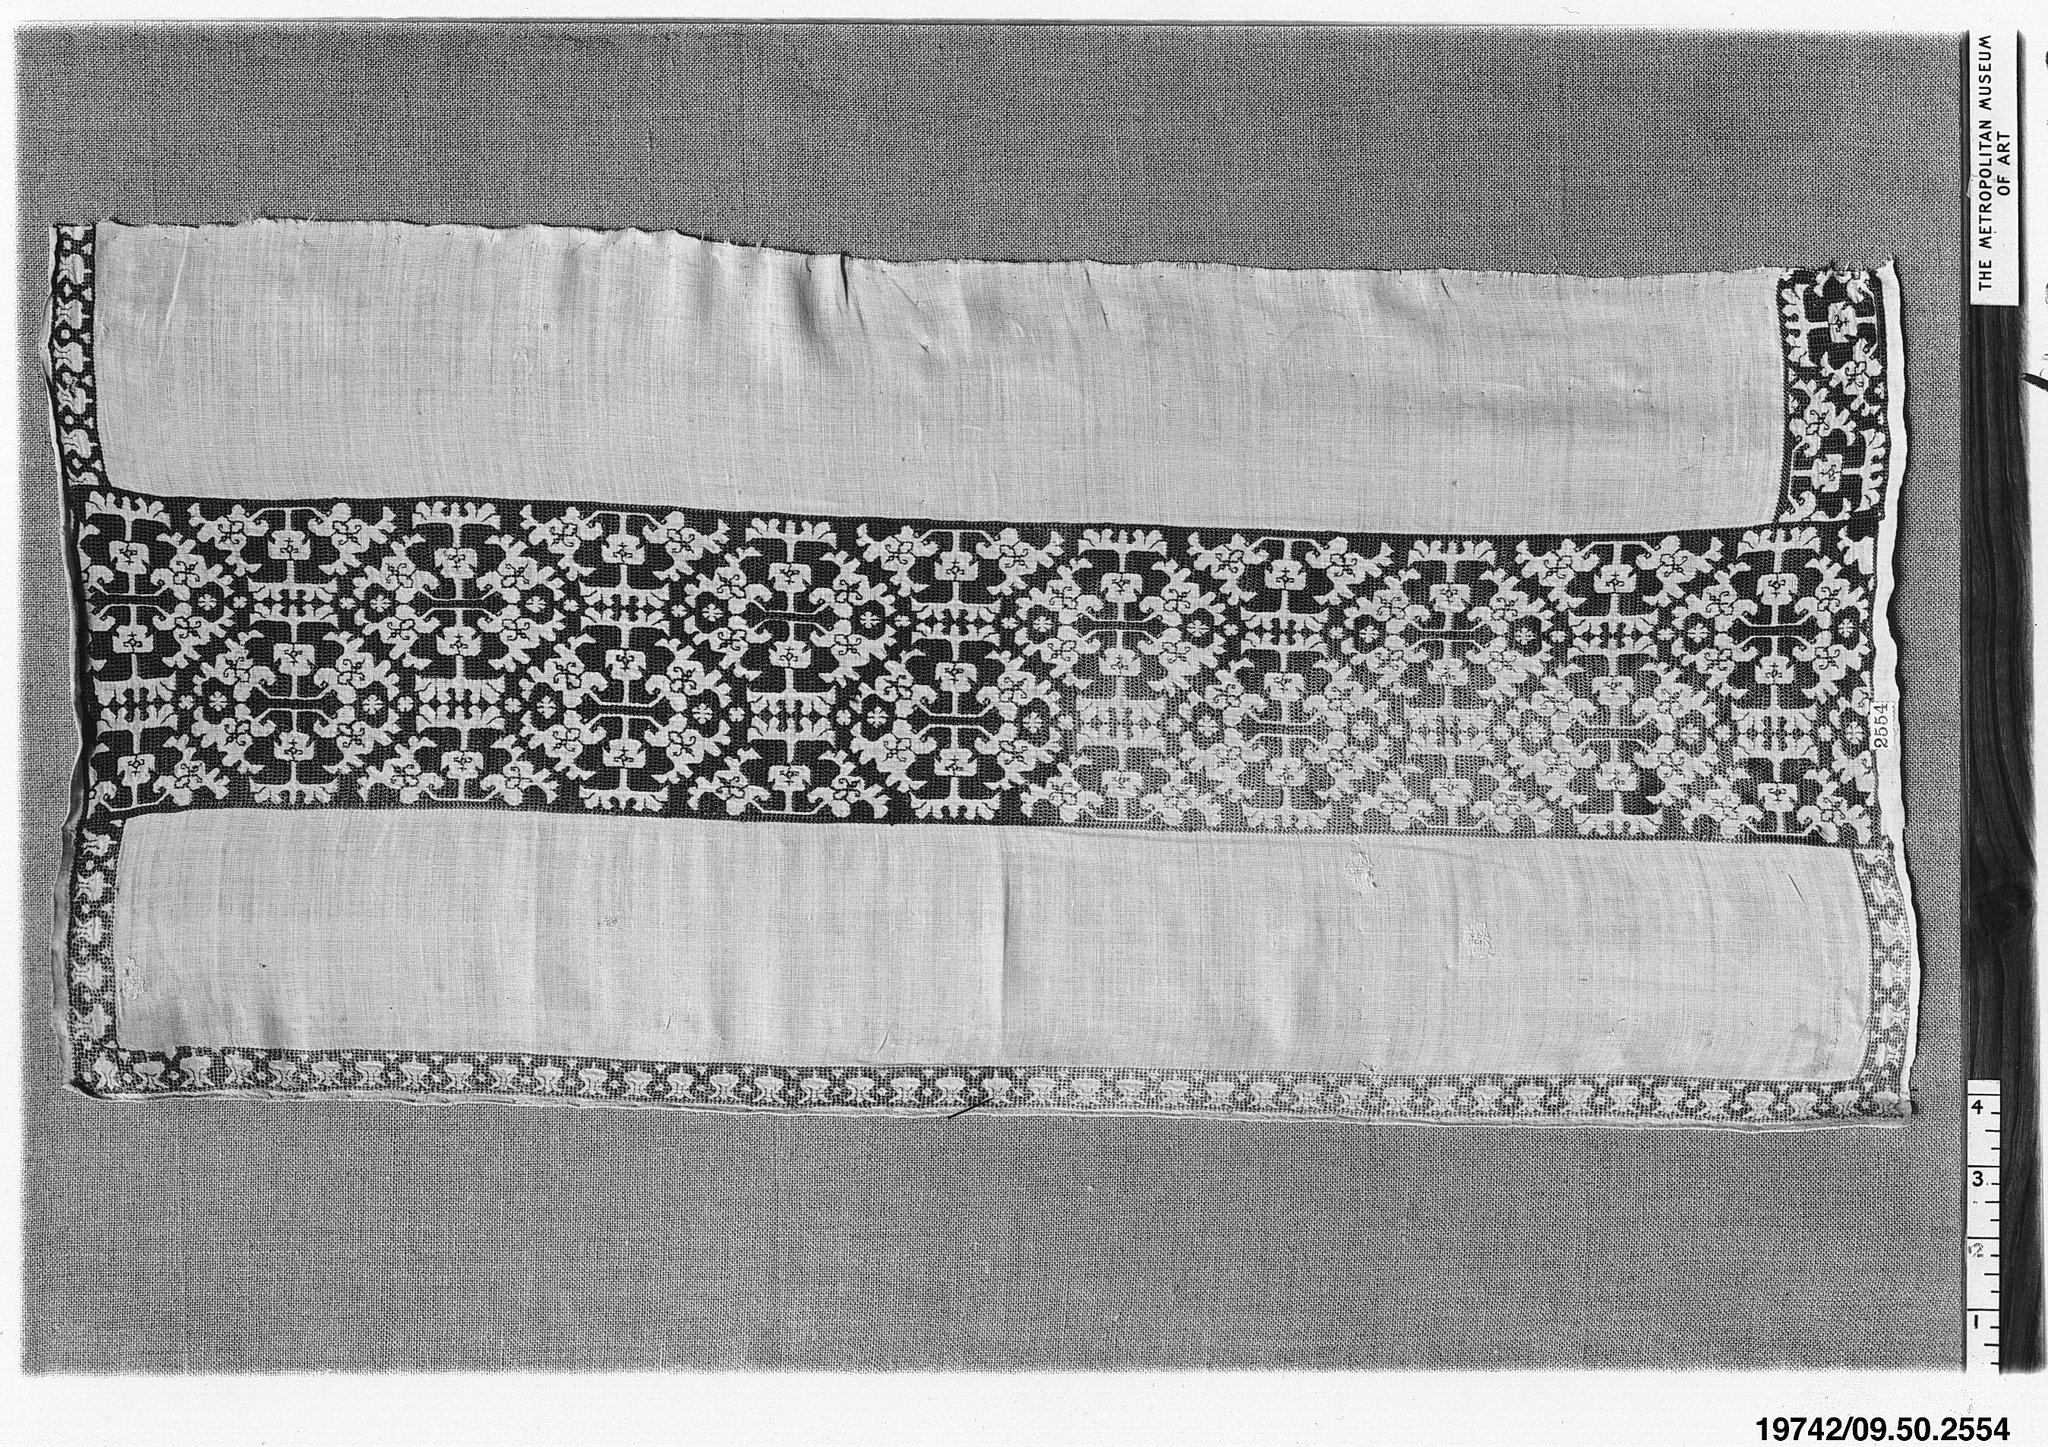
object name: panel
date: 1501-1700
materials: linen, silk